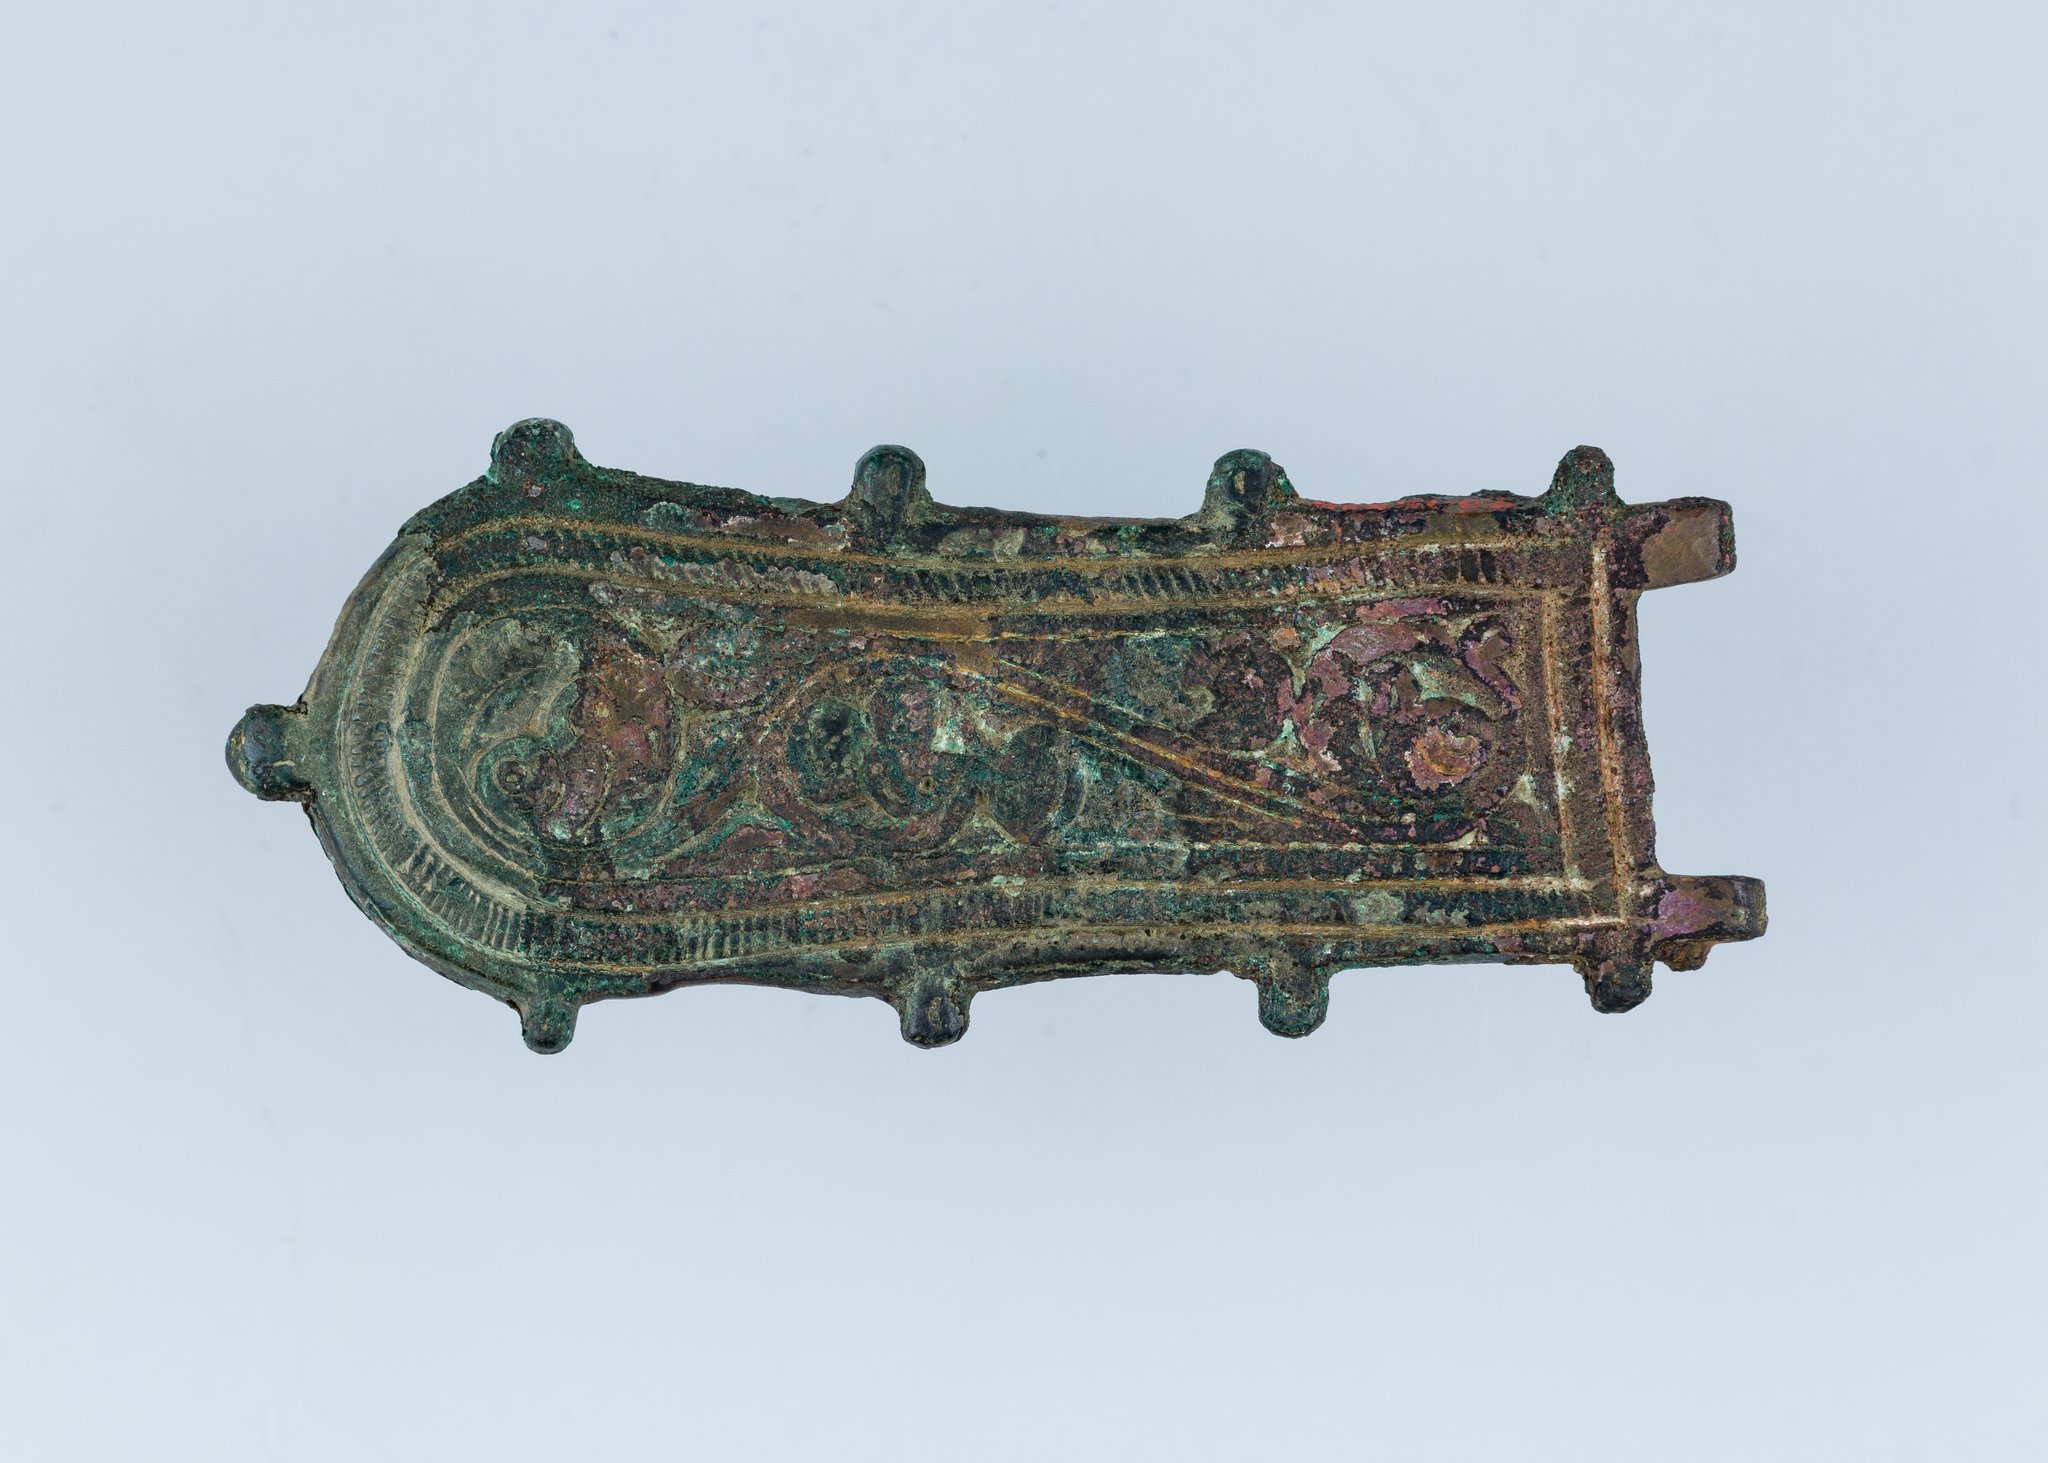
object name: buckle shank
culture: visigothic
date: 401-700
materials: bronze